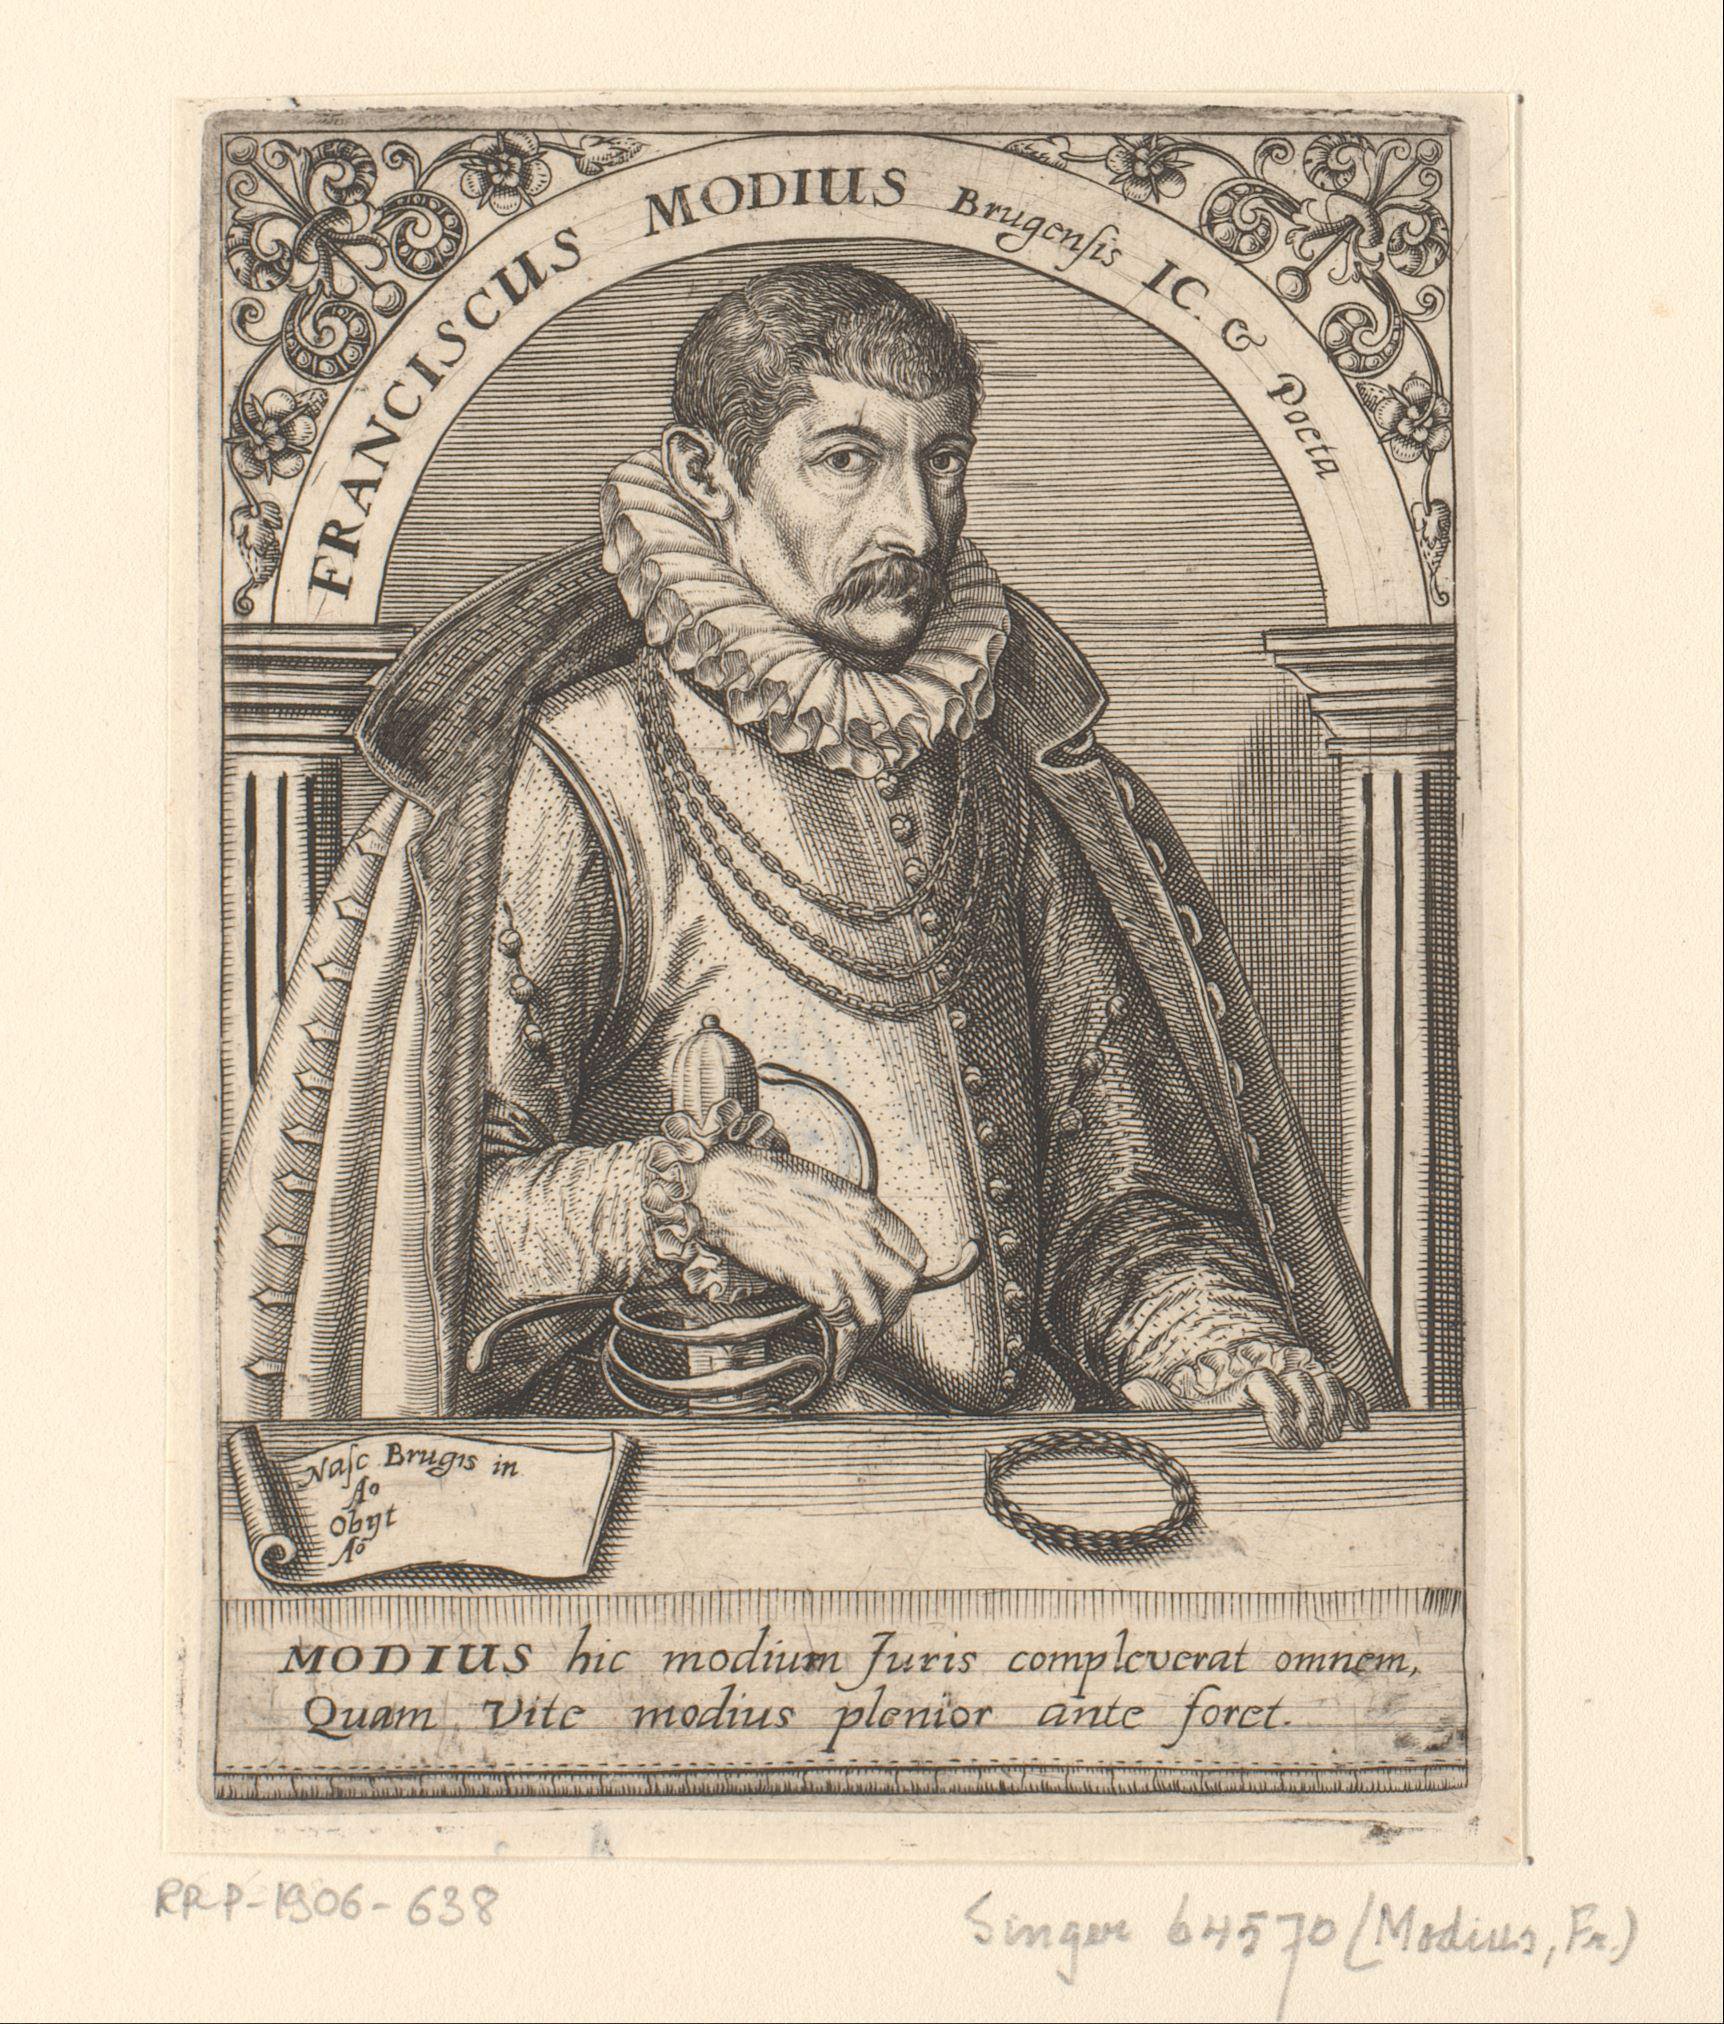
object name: book illustration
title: Portret van Franciscus Modius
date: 1597-1599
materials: paper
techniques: engraving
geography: frankfurt am main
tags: franciscus modius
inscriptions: collector's mark: Lugt 2228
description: Gemaakt voor: J.J. Boissard, Icones virorum illustrium doctrina &c eruditione praestanti um contines. Frankfurt am Main: de Bry, 1597-1599.